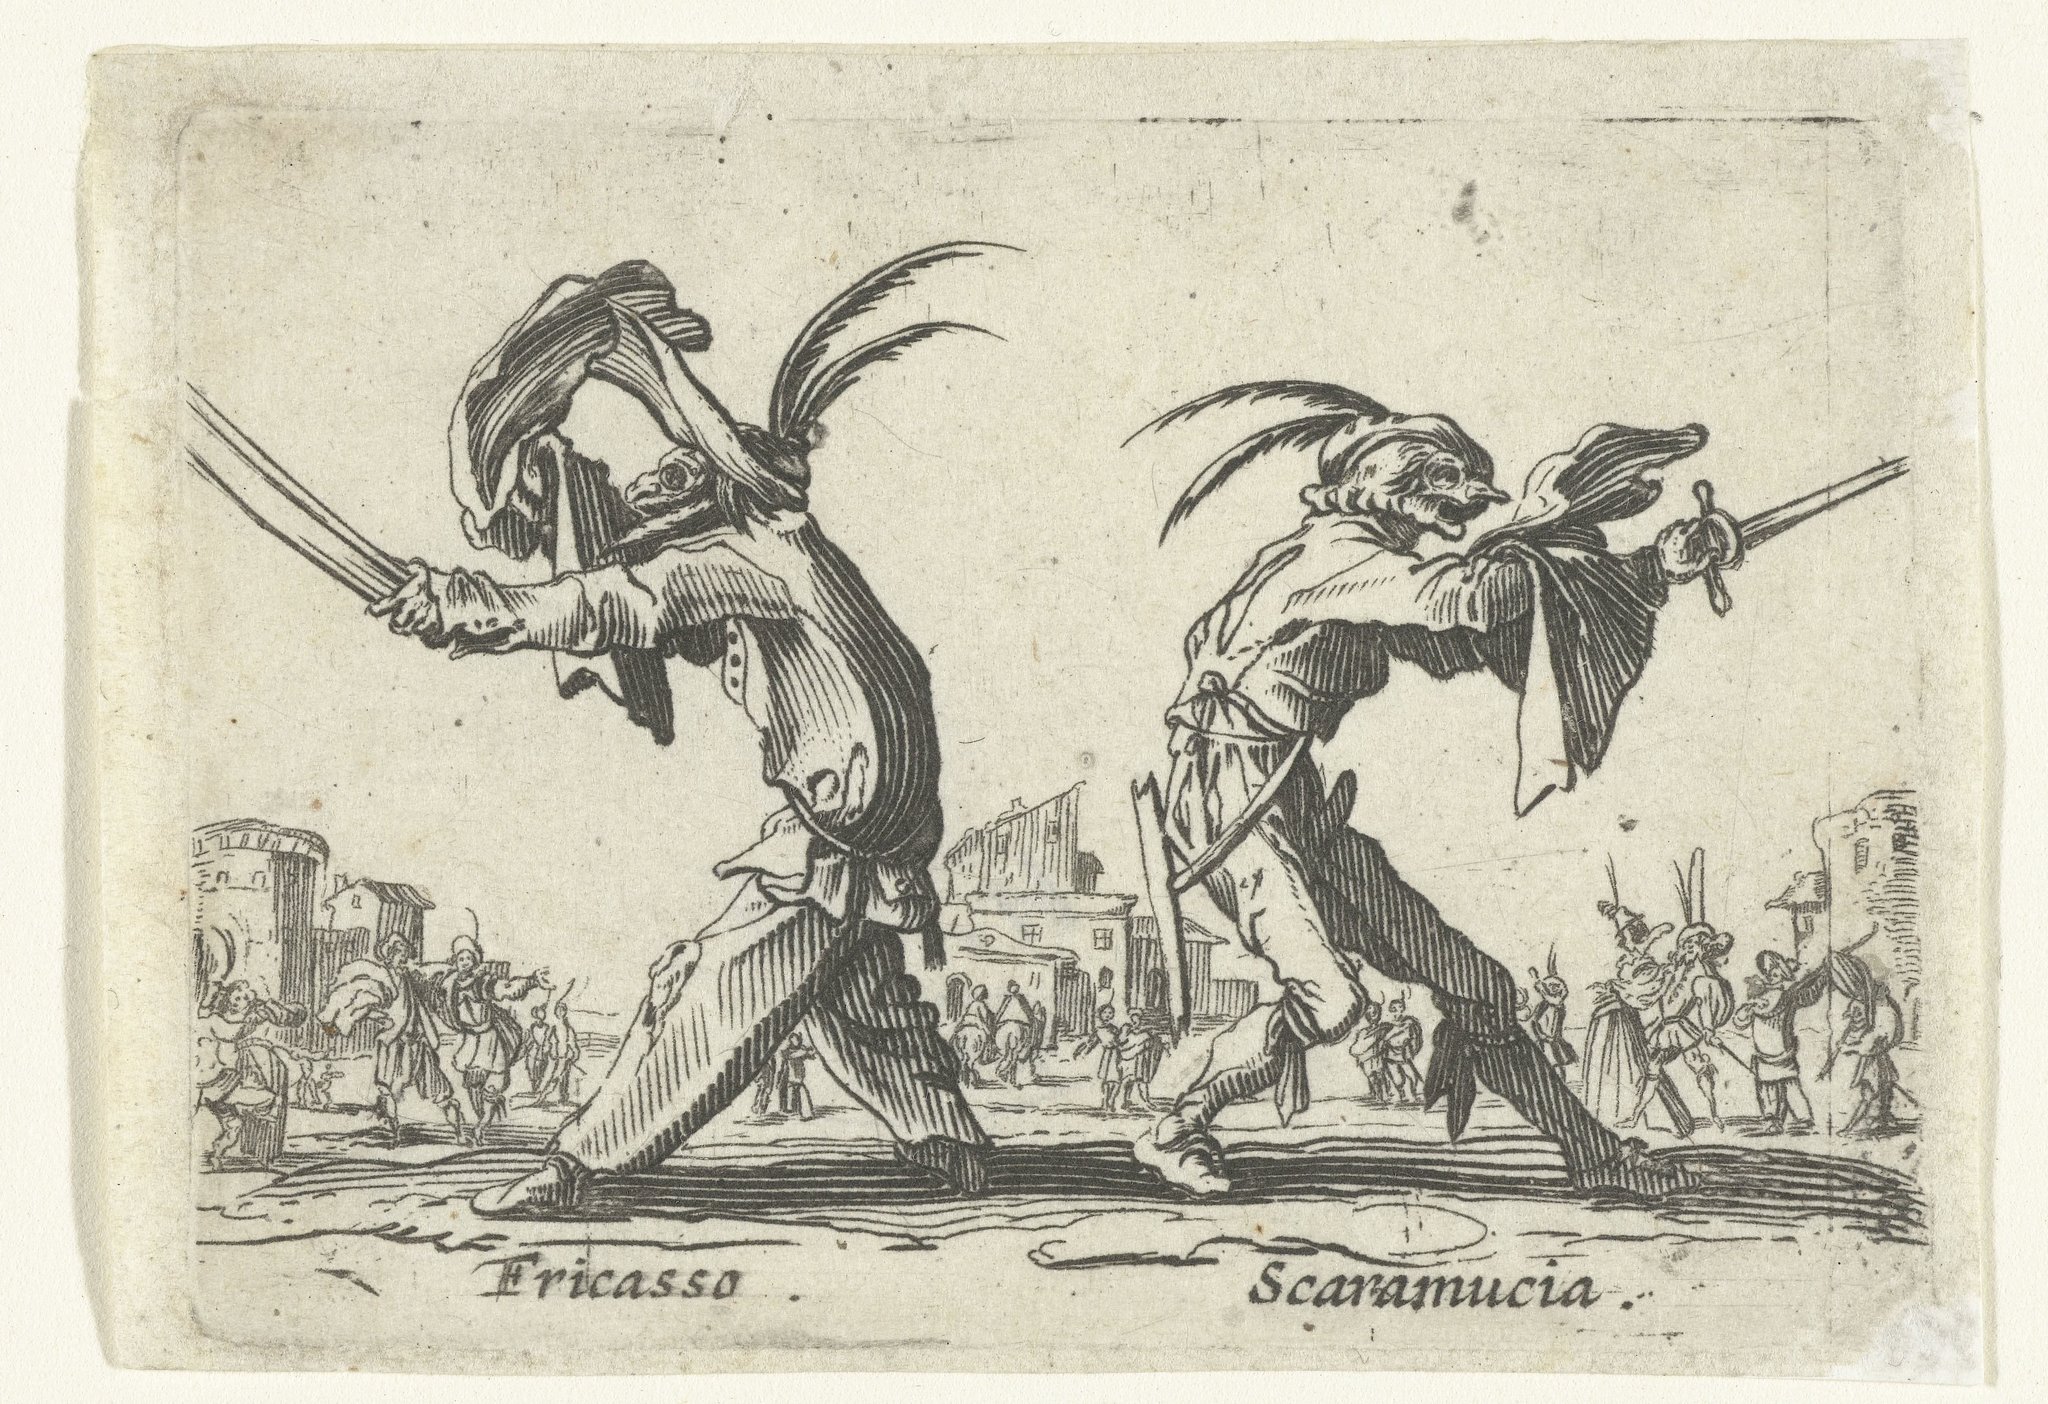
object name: print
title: Twee straatartiesten als Fricasso en Scaramucia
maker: Anonymous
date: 1622-1670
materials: paper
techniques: etching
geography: low countries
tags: types in 'commedia dell'arte'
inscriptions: collector's mark: Lugt 2228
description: Twee artiesten met gevederde hoofddeksels op en met getrokken zwaarden in de hand staan met de rug naar elkaar toe. Onder de figuren staan hun namen genoteerd. Deze prent is onderdeel van een serie van 23 prenten (24 incl. titelprent) met telkens op de voorgrond twee straatartiesten verkleed als figuren uit de Italiaanse commedia dell'arte, en op de achtergrond toeschouwers die in de buitenlucht een (dans)voorstelling van straatartiesten gadeslaan.